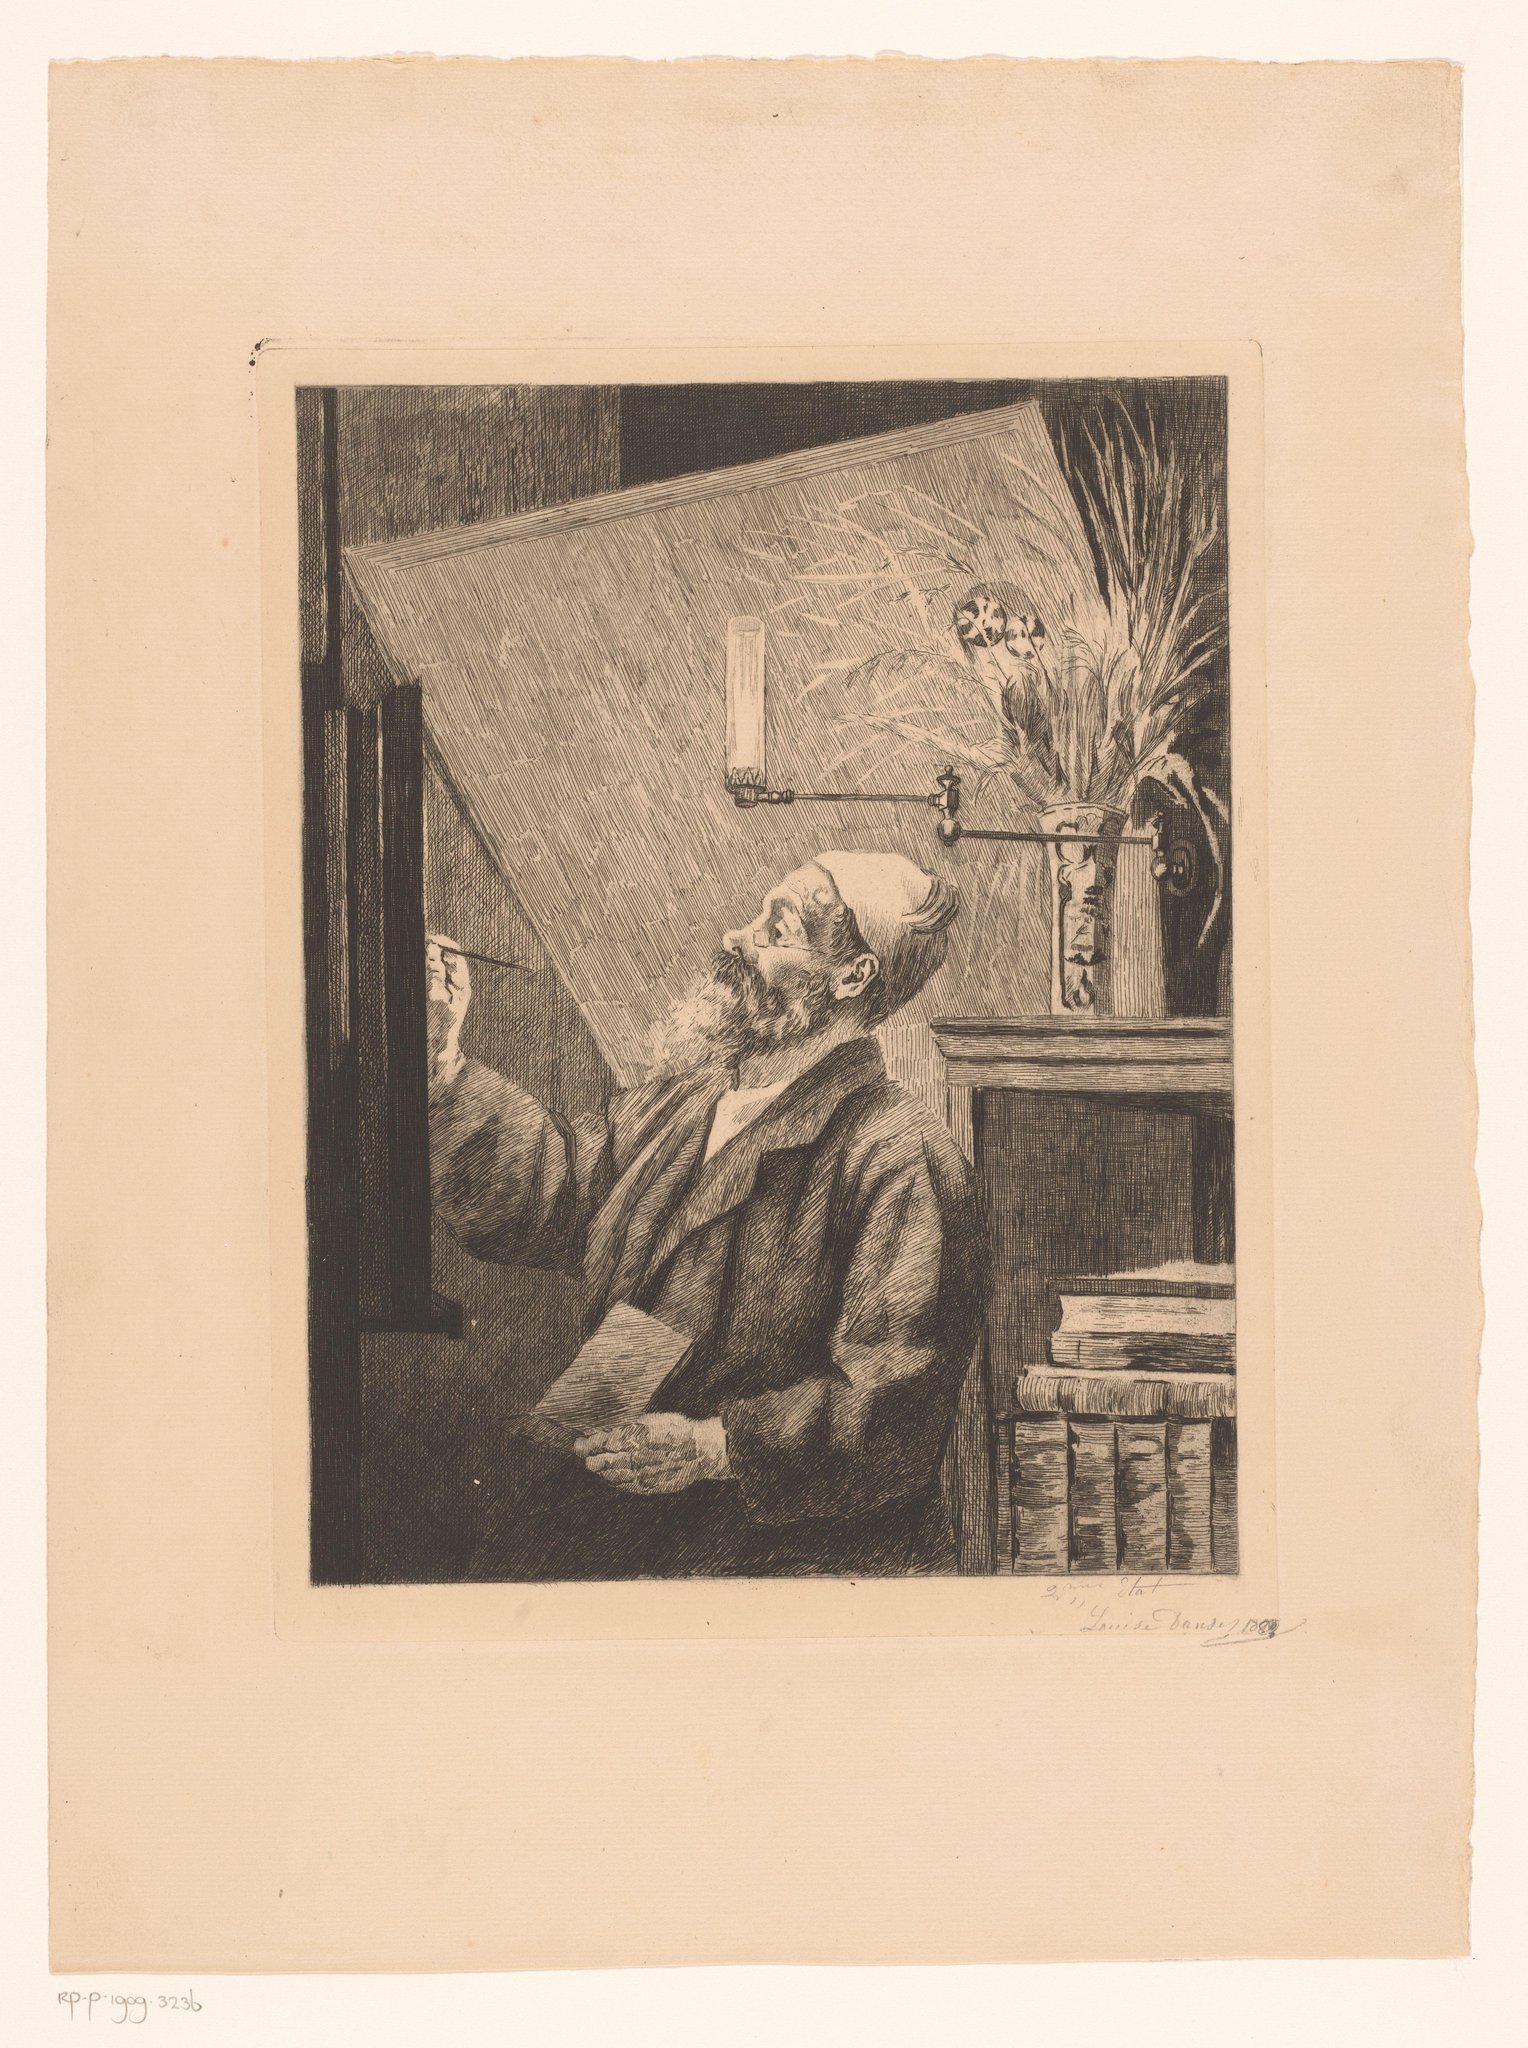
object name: print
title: Auguste Danse aan de schildersezel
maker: louise danse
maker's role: painter, print maker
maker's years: 1867-1948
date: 1883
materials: paper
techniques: drypoint, etching, intaglio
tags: painter at work, in his studio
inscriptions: collector's mark: Lugt 2228, annotation: ‘2eme Etat’